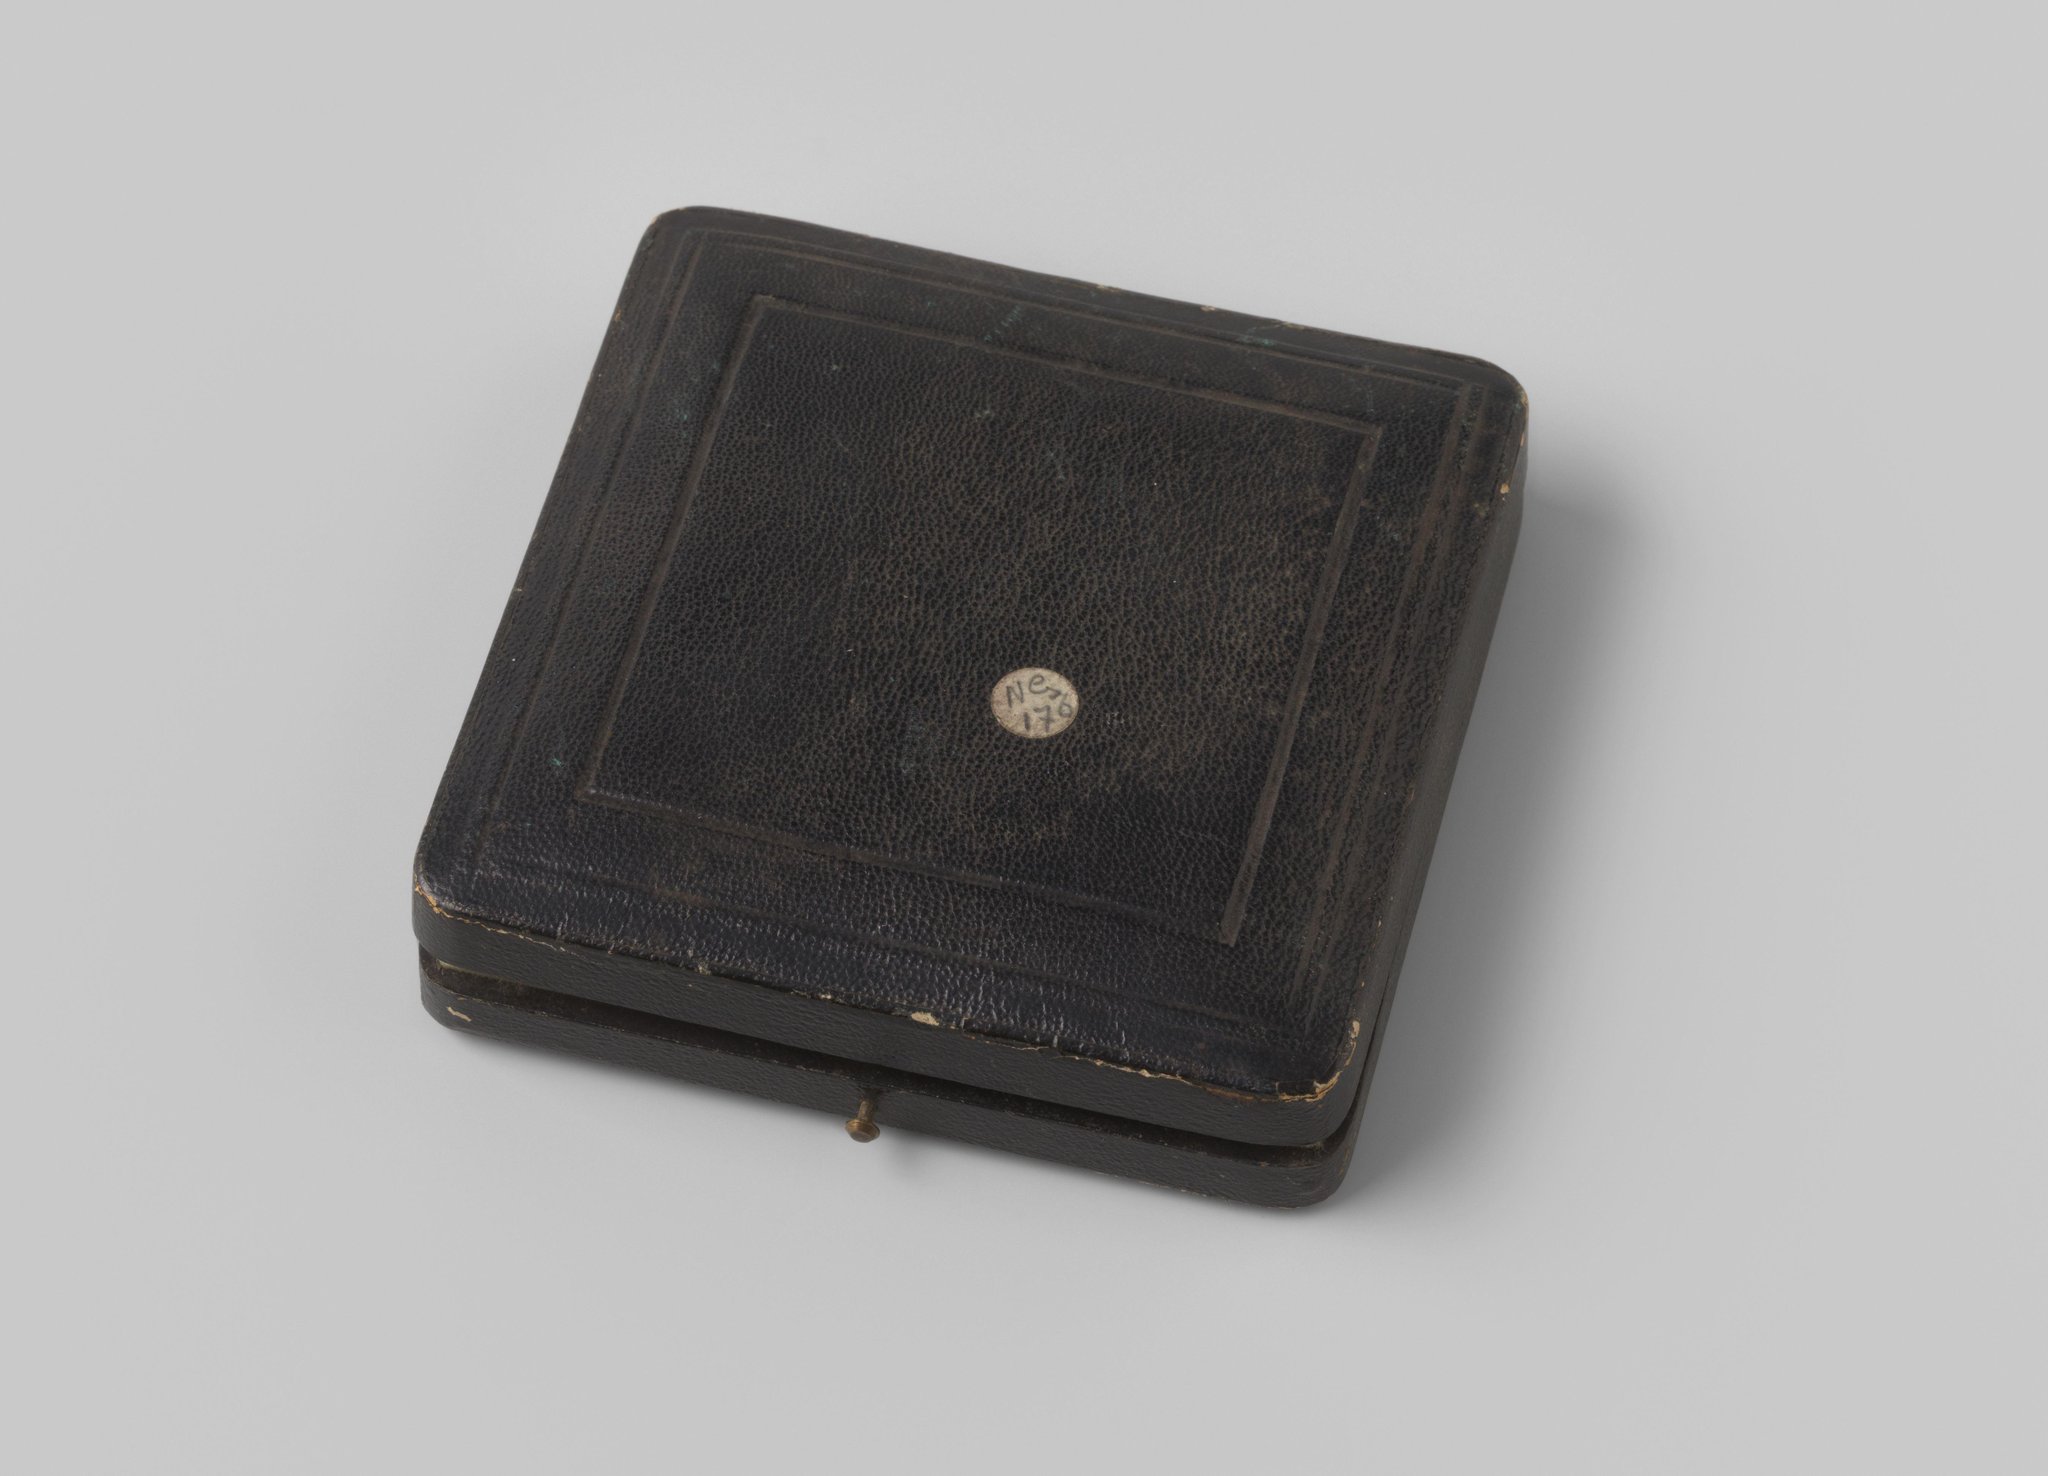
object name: box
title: Doos horend bij een bronzen penning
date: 1883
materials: cardboard, velvet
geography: antwerp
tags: brussels, willem iii (koning der nederlanden)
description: Vierkant leren doosje. Binnenzijde is bekleedt met groen fluweel.